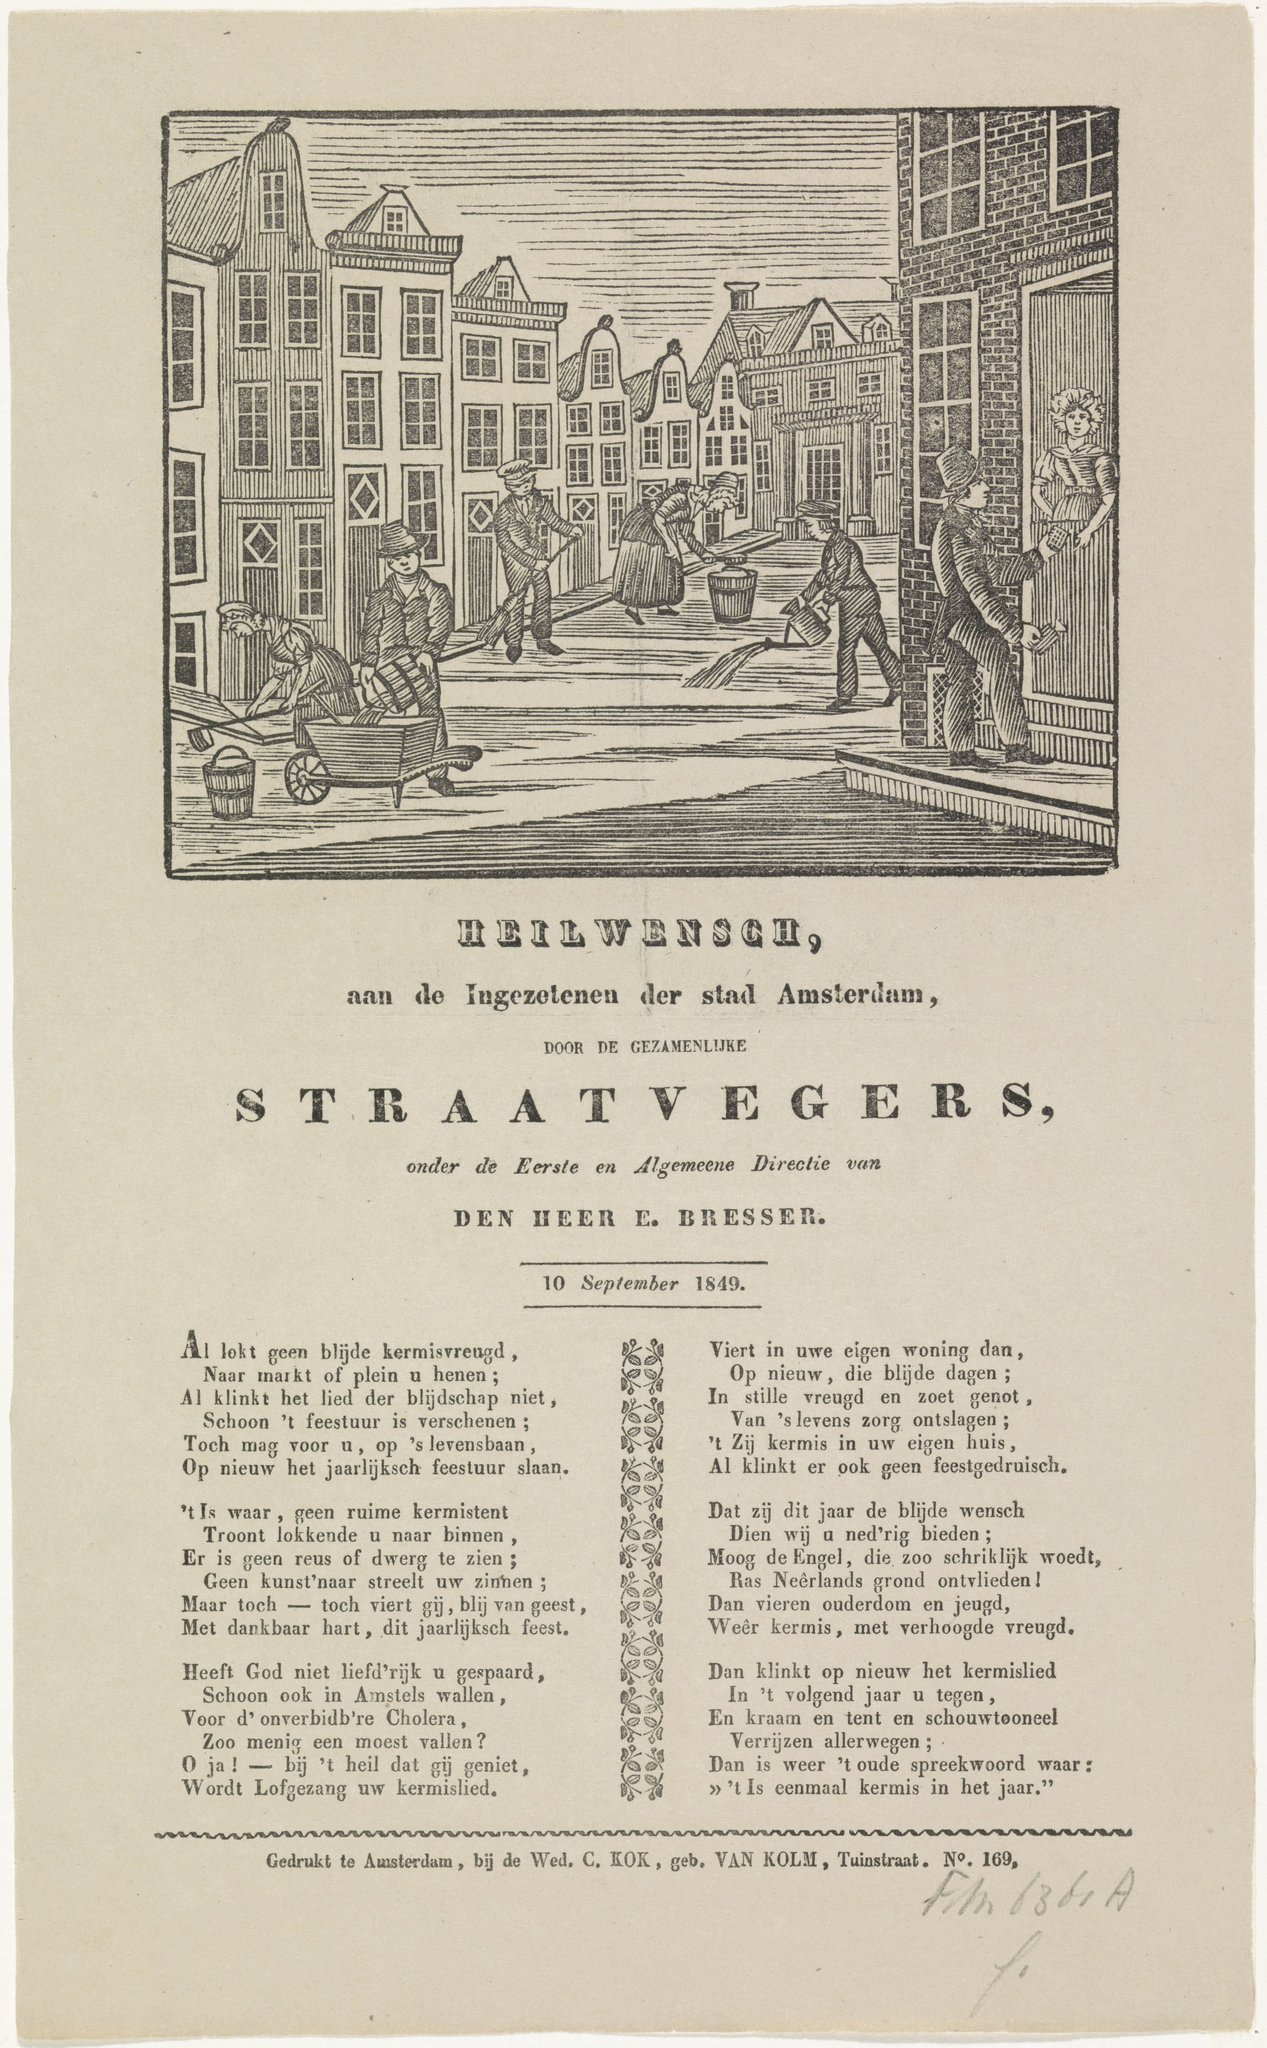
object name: print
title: Heilwensch (...) door de gezamenlijke Straatvegers onder de eerste en algemeene directie van den heer E. Bresser (...) 1849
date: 1849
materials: paper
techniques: letterpress printing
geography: amsterdam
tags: street - ii - ideal city, street sweeping, street sweeper, amsterdam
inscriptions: collector's mark: Lugt 2228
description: Kermisprent van de Amsterdamse straatvegers, 10 september 1849. Gezicht in een Amsterdamse straat waar meerdere mannelijke en vrouwelijke stratenvegers aan het werk zijn, op de voorgrond haalt een man geld op bij een huis. Met een vers in twee kolommen.